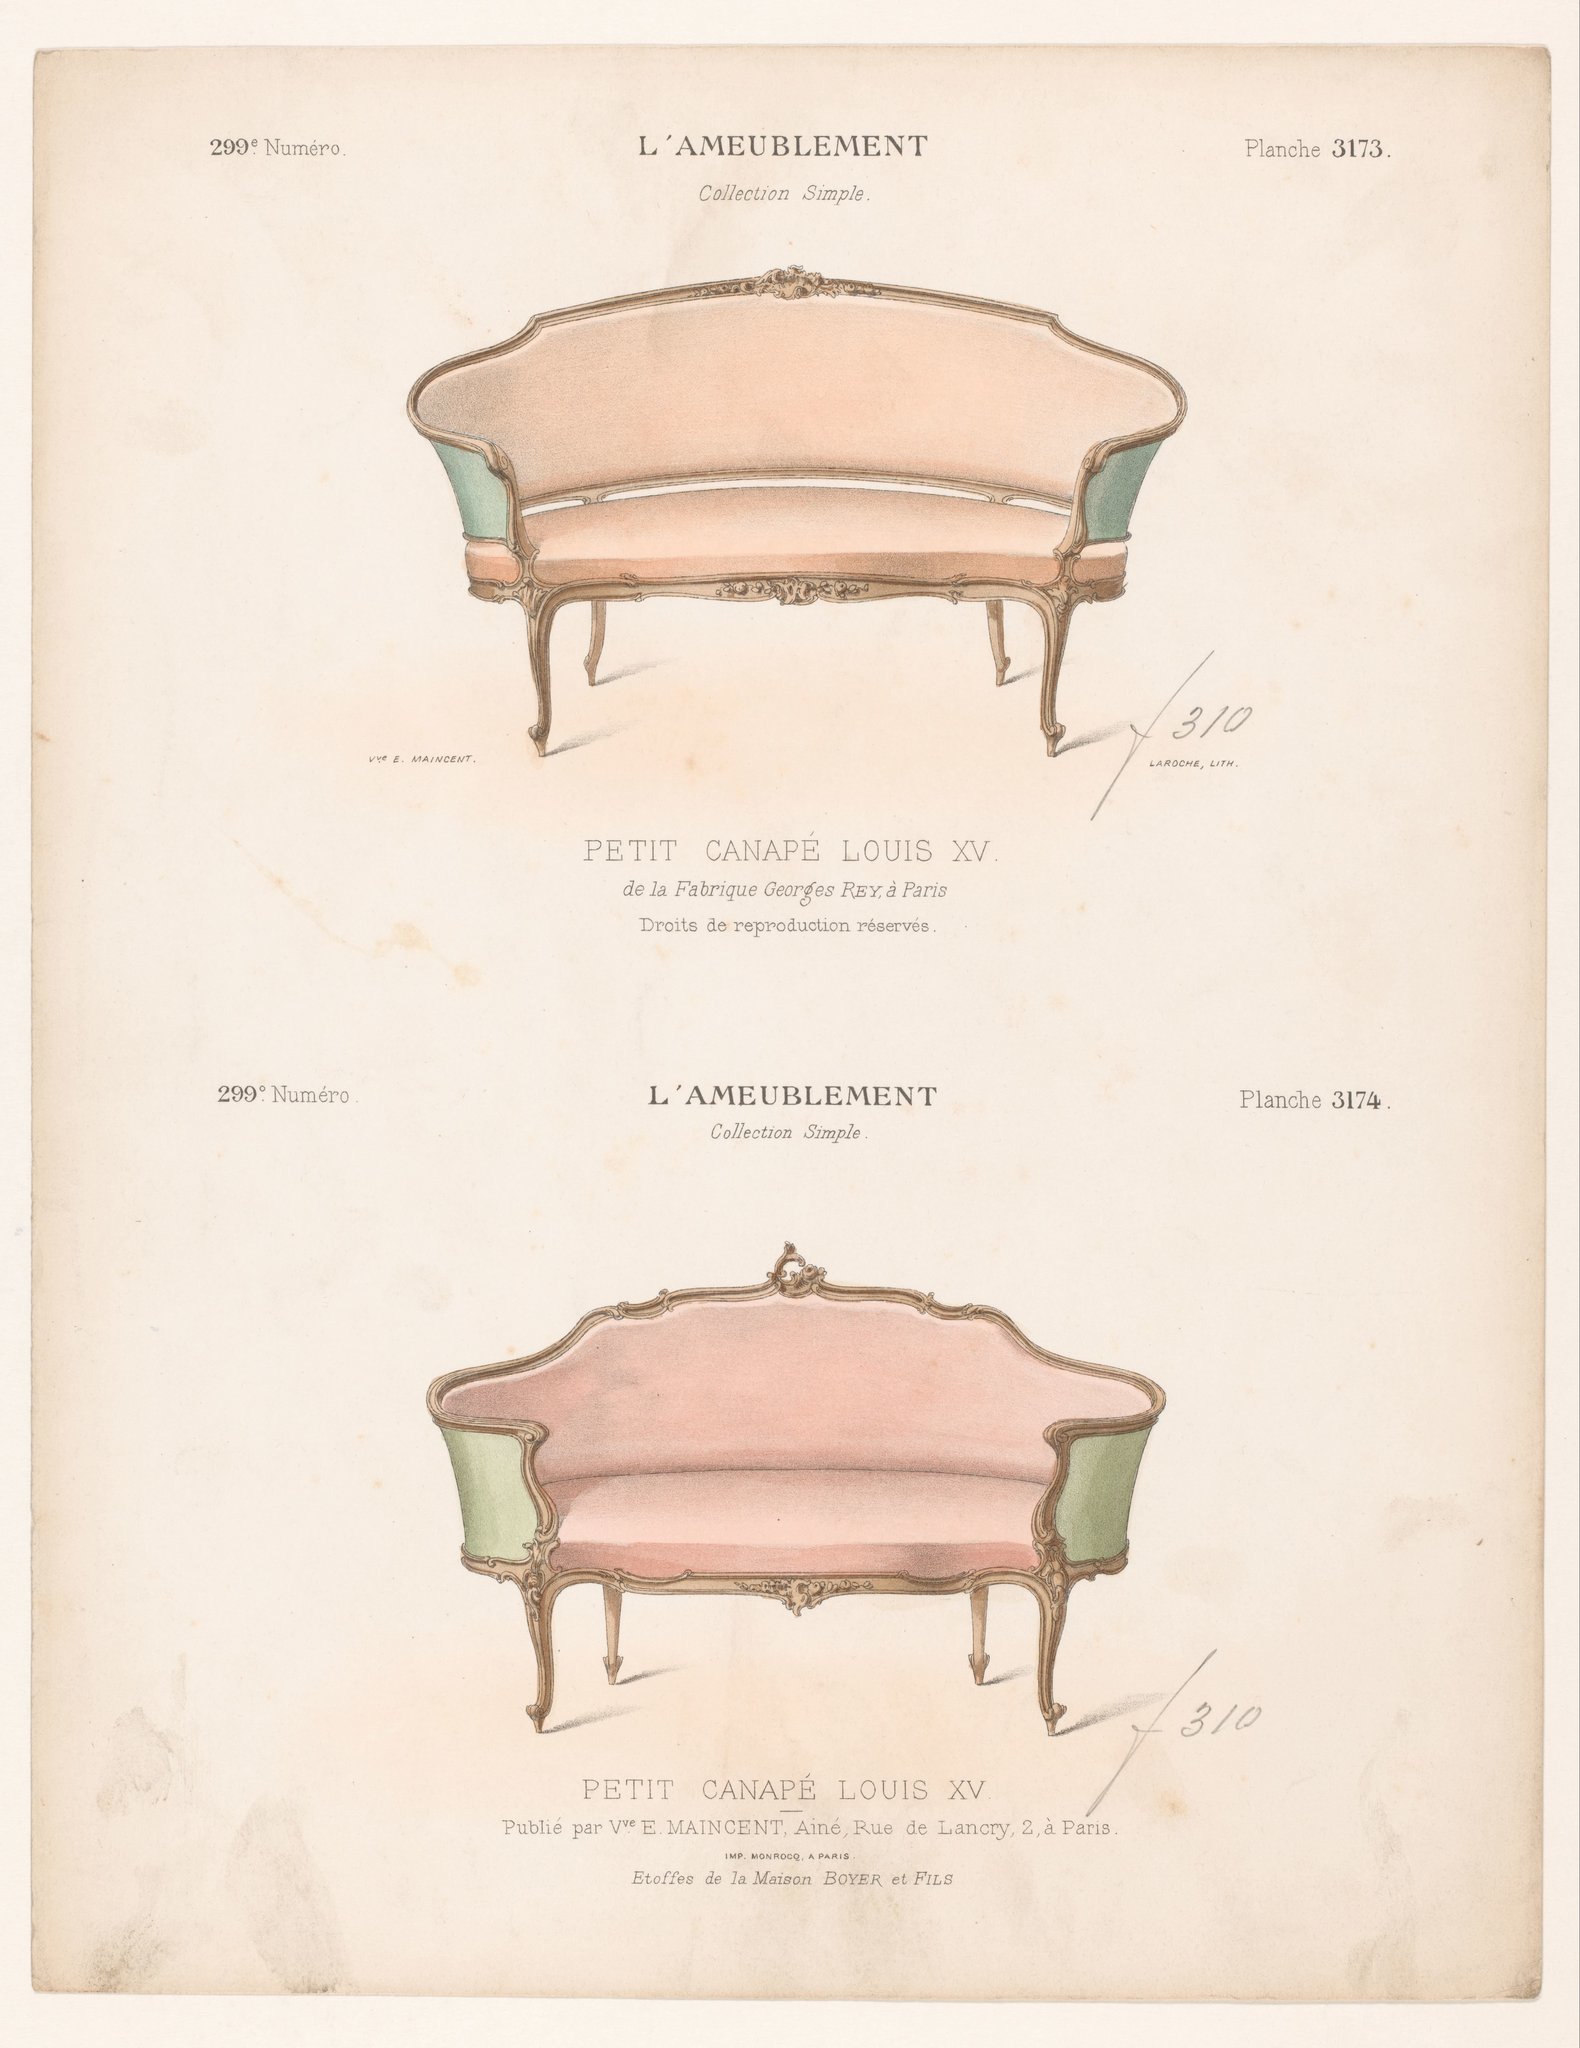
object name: print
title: Twee canapés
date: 1895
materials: paper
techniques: hand coloring, lithograph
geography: paris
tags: seating furniture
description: Twee canapés in de Lodewijk XV-stijl. Prent uit 298e nummer (livraison).